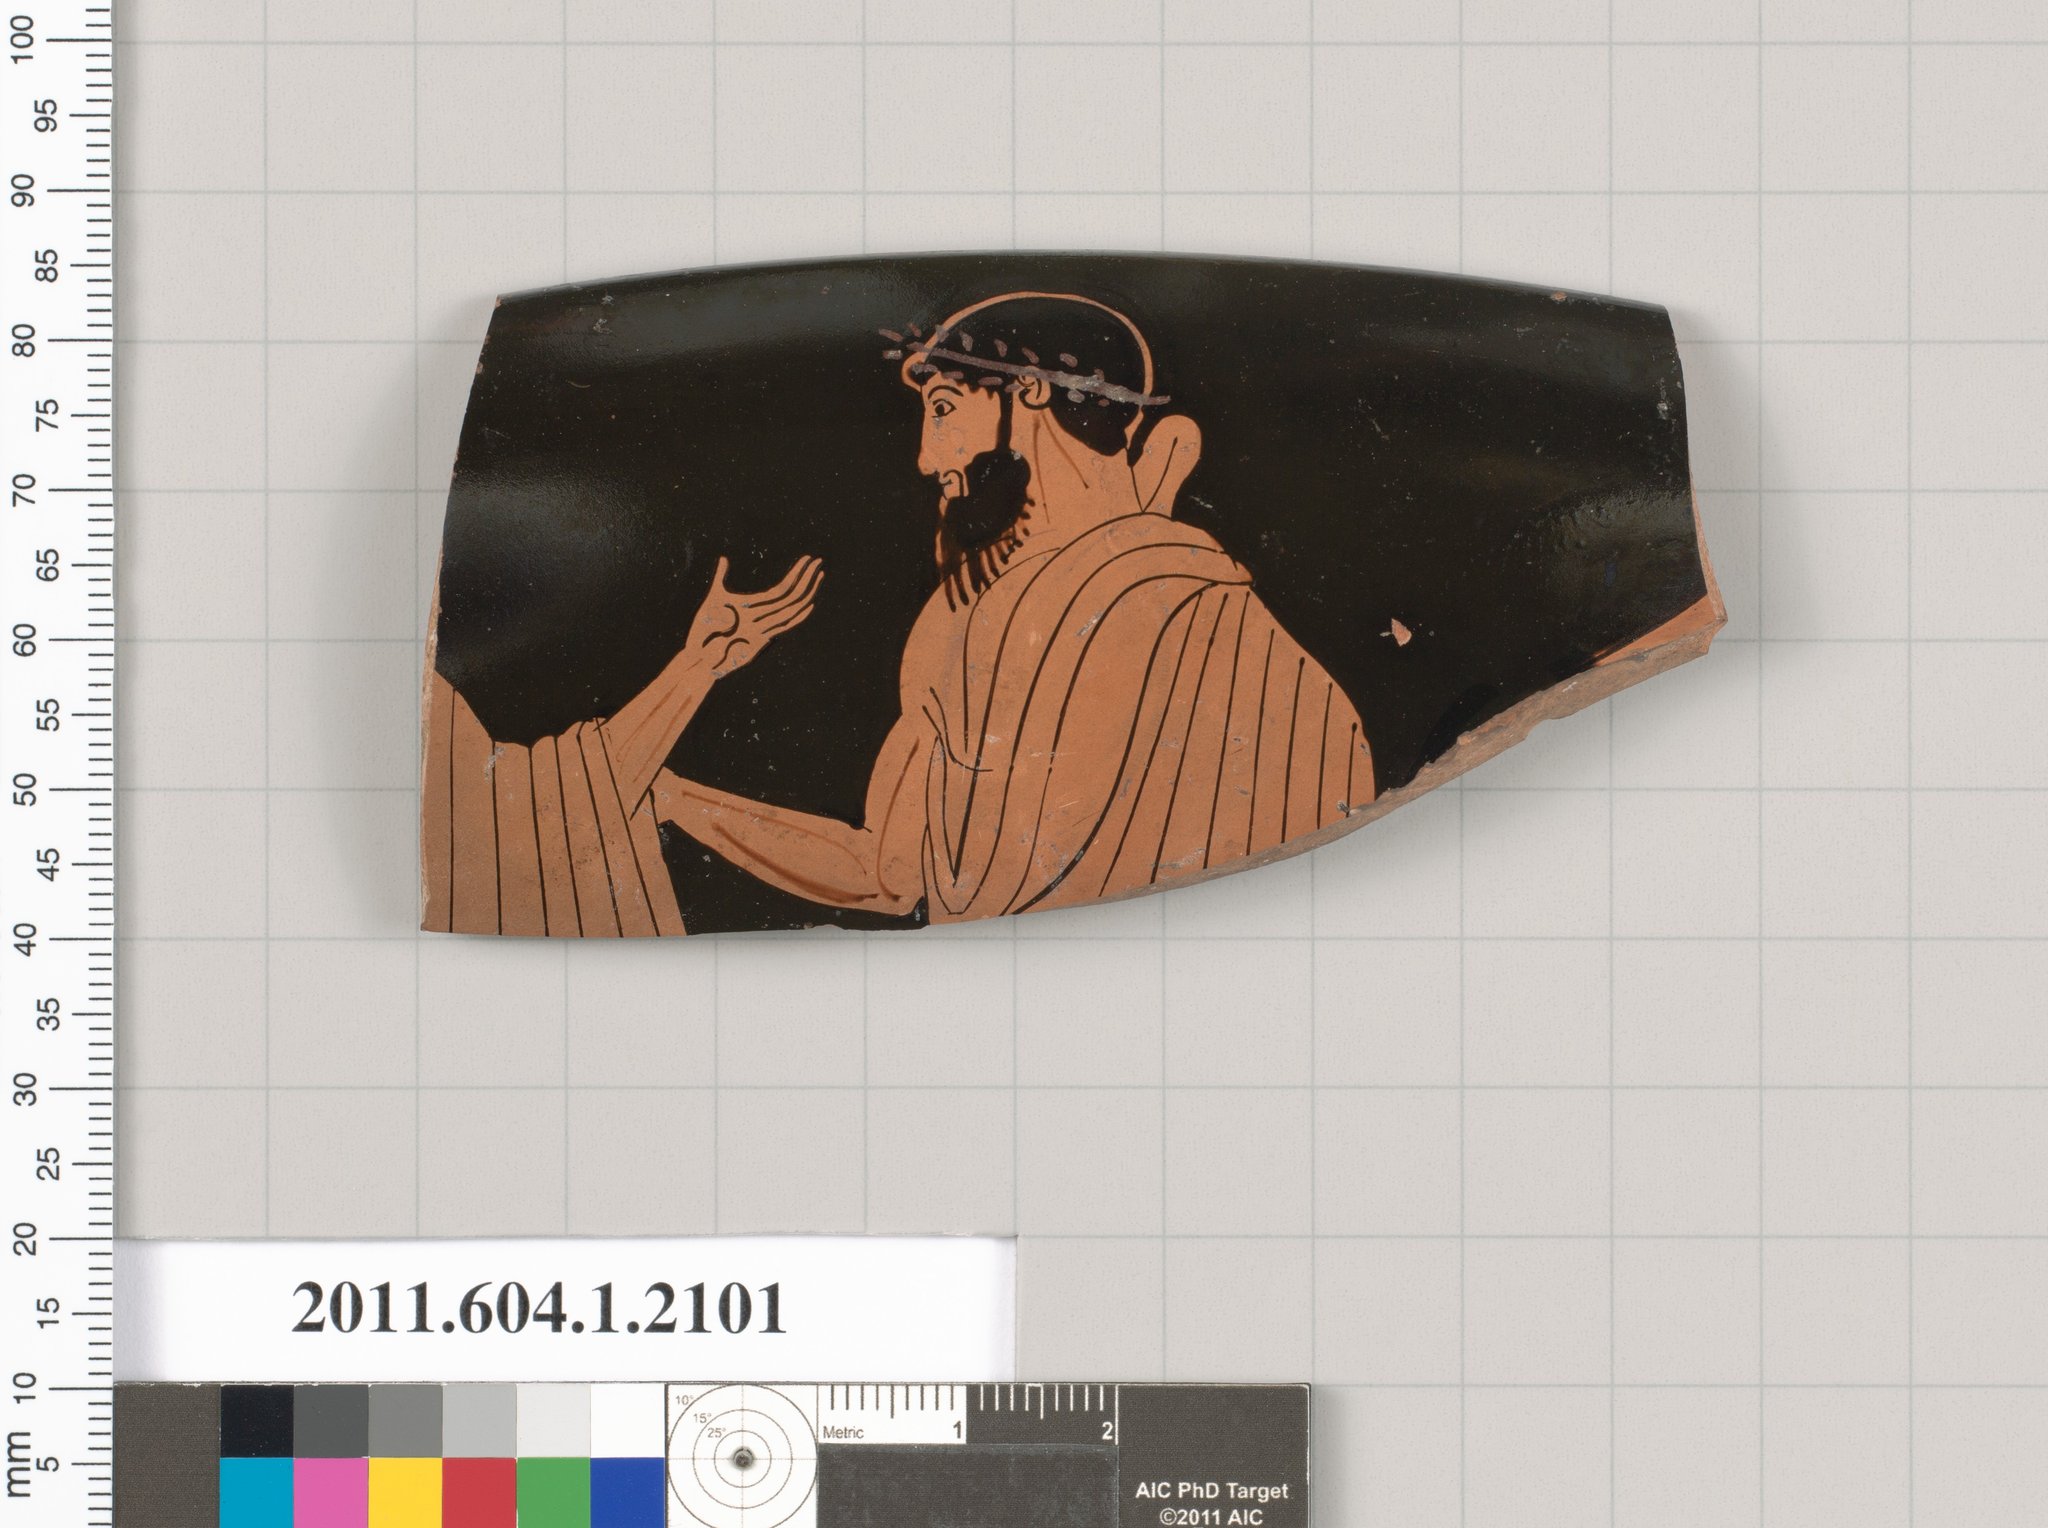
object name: kylix fragment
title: Terracotta rim fragment of a kylix (drinking cup)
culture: greek, attic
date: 475-451 BCE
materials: terracotta